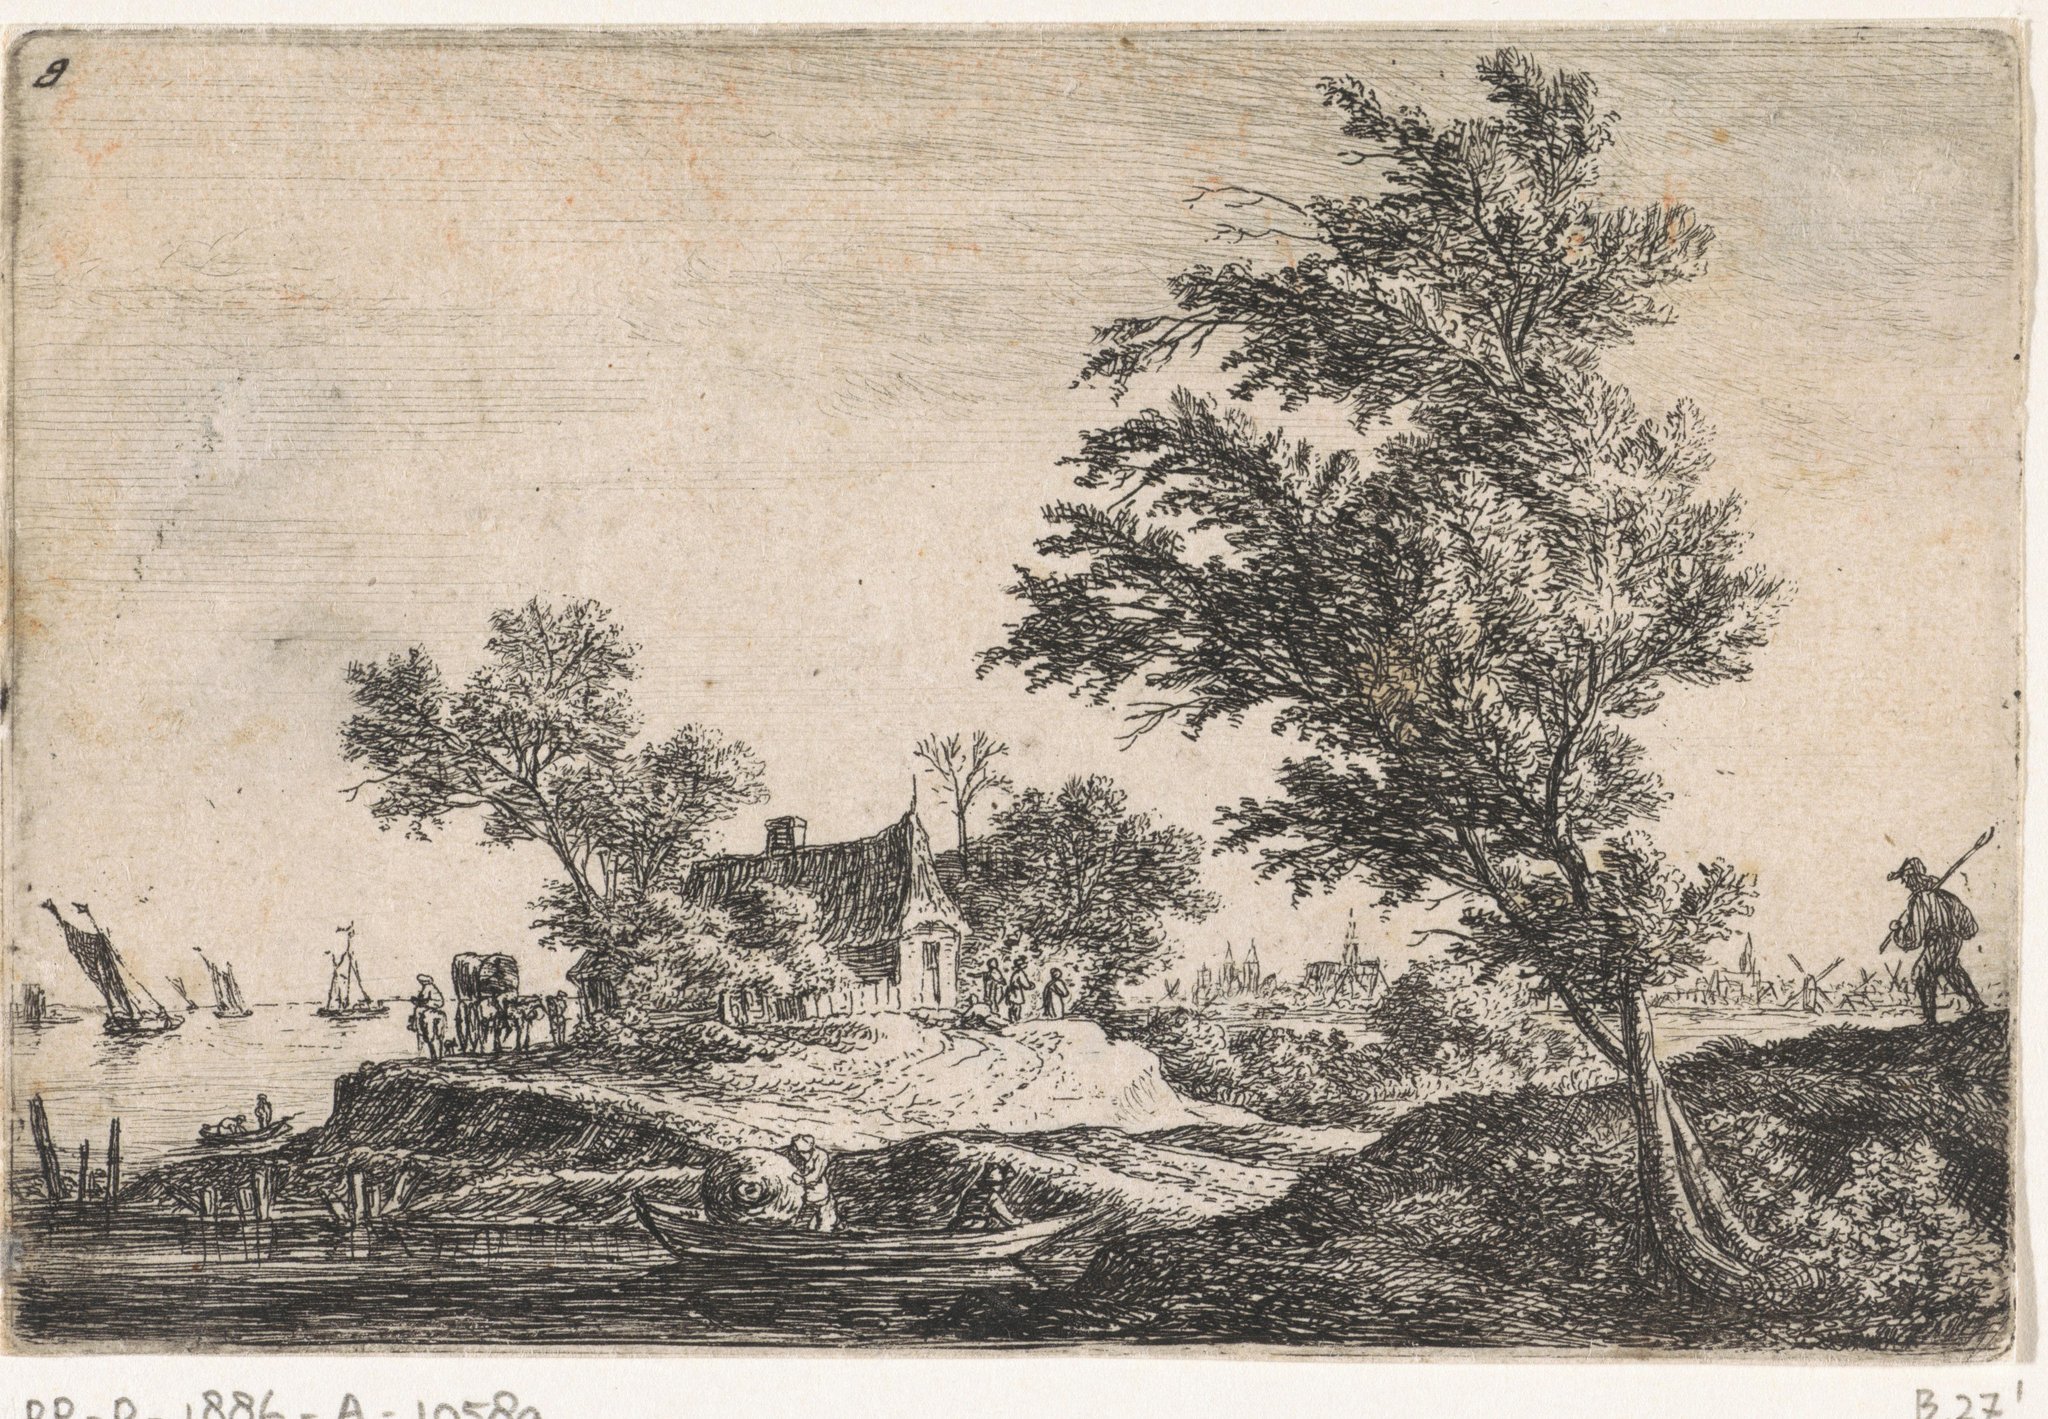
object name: print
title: Huis aan het water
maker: anthonie waterloo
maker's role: draughtsman, painter, print maker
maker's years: 1609-1690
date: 1630-1663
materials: paper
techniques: etching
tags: city-view, and landscape with man-made constructions, sailing-ship, sailing-boat, landscapes with waters, waterscapes, seascapes (in the temperate zone), rural housing, e.g. country-house, villa, cottage, rowing-boat, canoe, etc., 'en route', traveller under way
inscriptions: collector's mark: Lugt 2228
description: Aan het water ligt een huis. In het water liggen boten. Rechts in de verte ligt een stad en vooraan rechts loopt een reiziger. Linksboven is de letter g te zien.